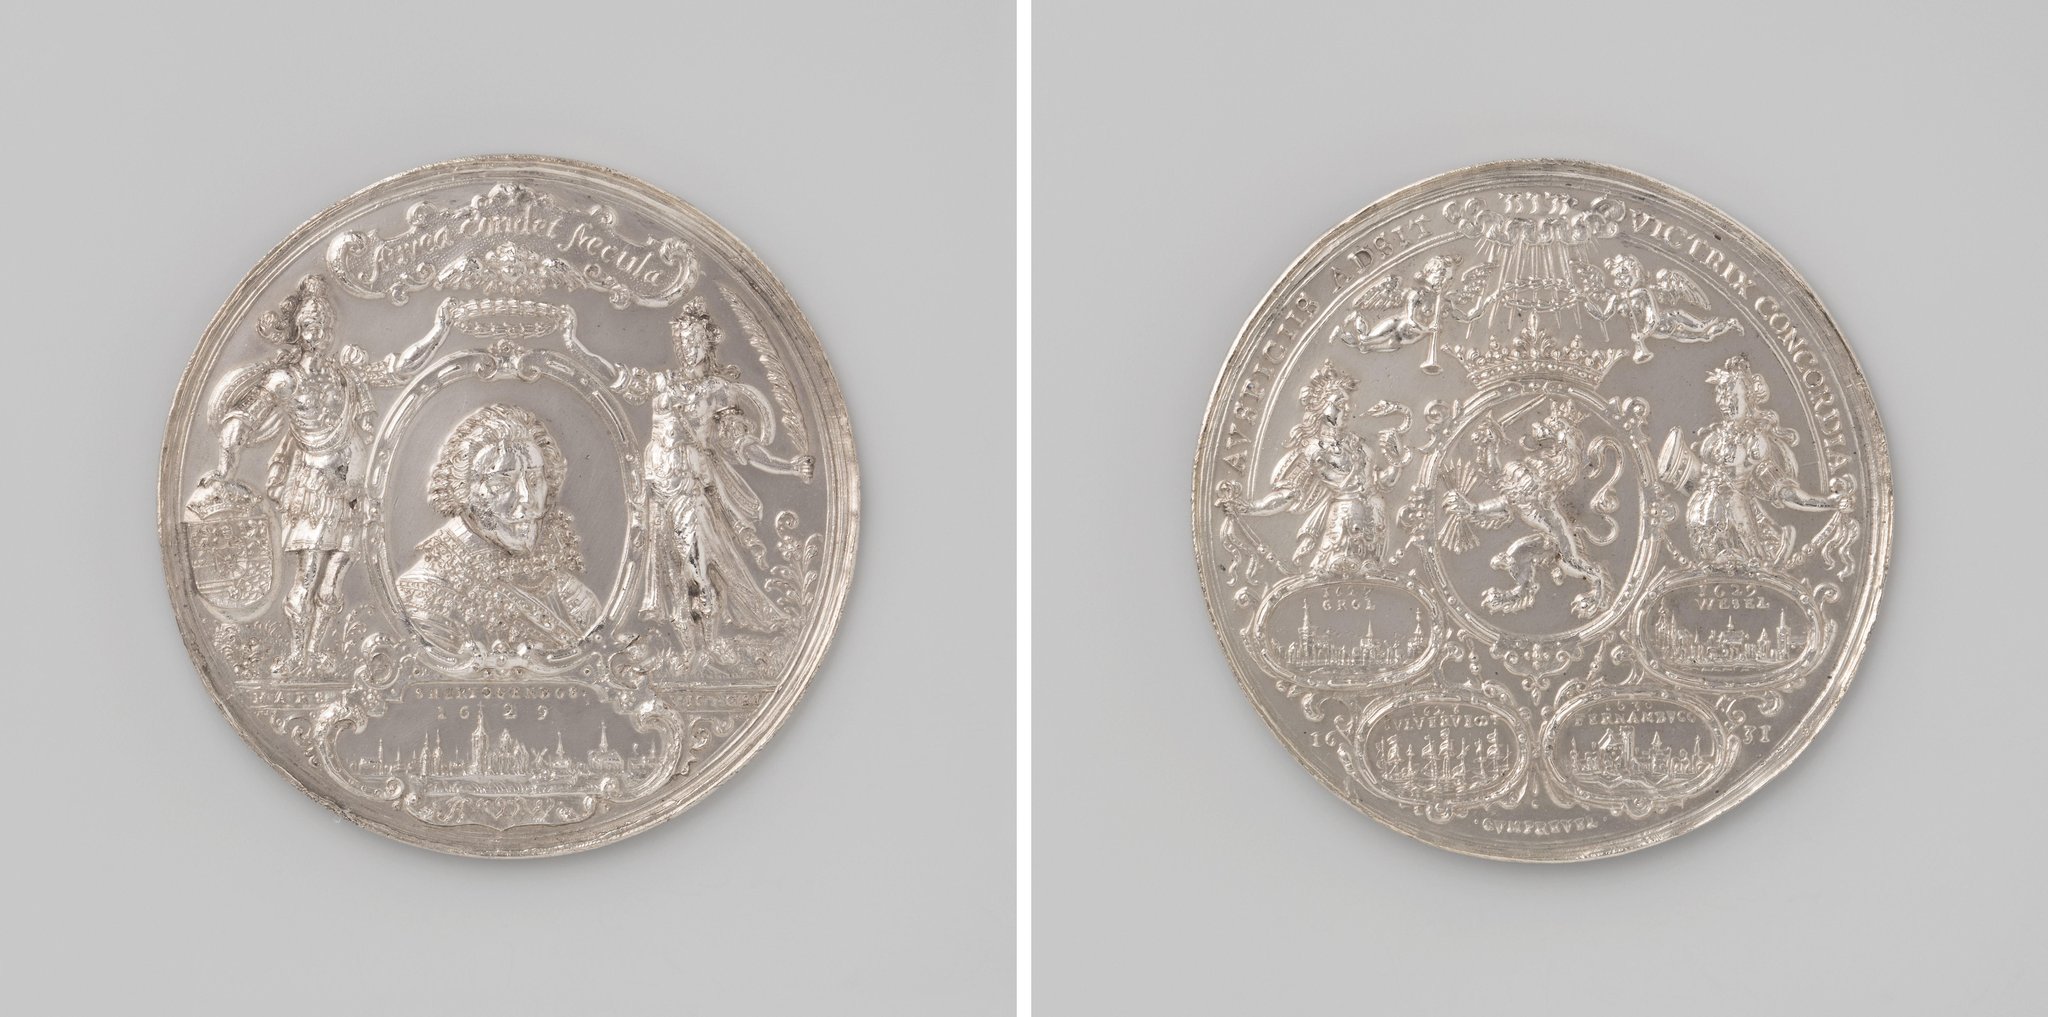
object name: triomfpenning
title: Verovering van Den Bosch, Groenlo, de zilvervloot, Pernambuco en Wezel door Frederik Hendrik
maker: anthonis pietersz. van der willigen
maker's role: draughtsman, print maker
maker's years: 1591-1640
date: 1630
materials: silver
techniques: striking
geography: the hague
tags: delft, the hague, frederick henry (prince of orange), den bosch, capture of the spanish treasure fleet